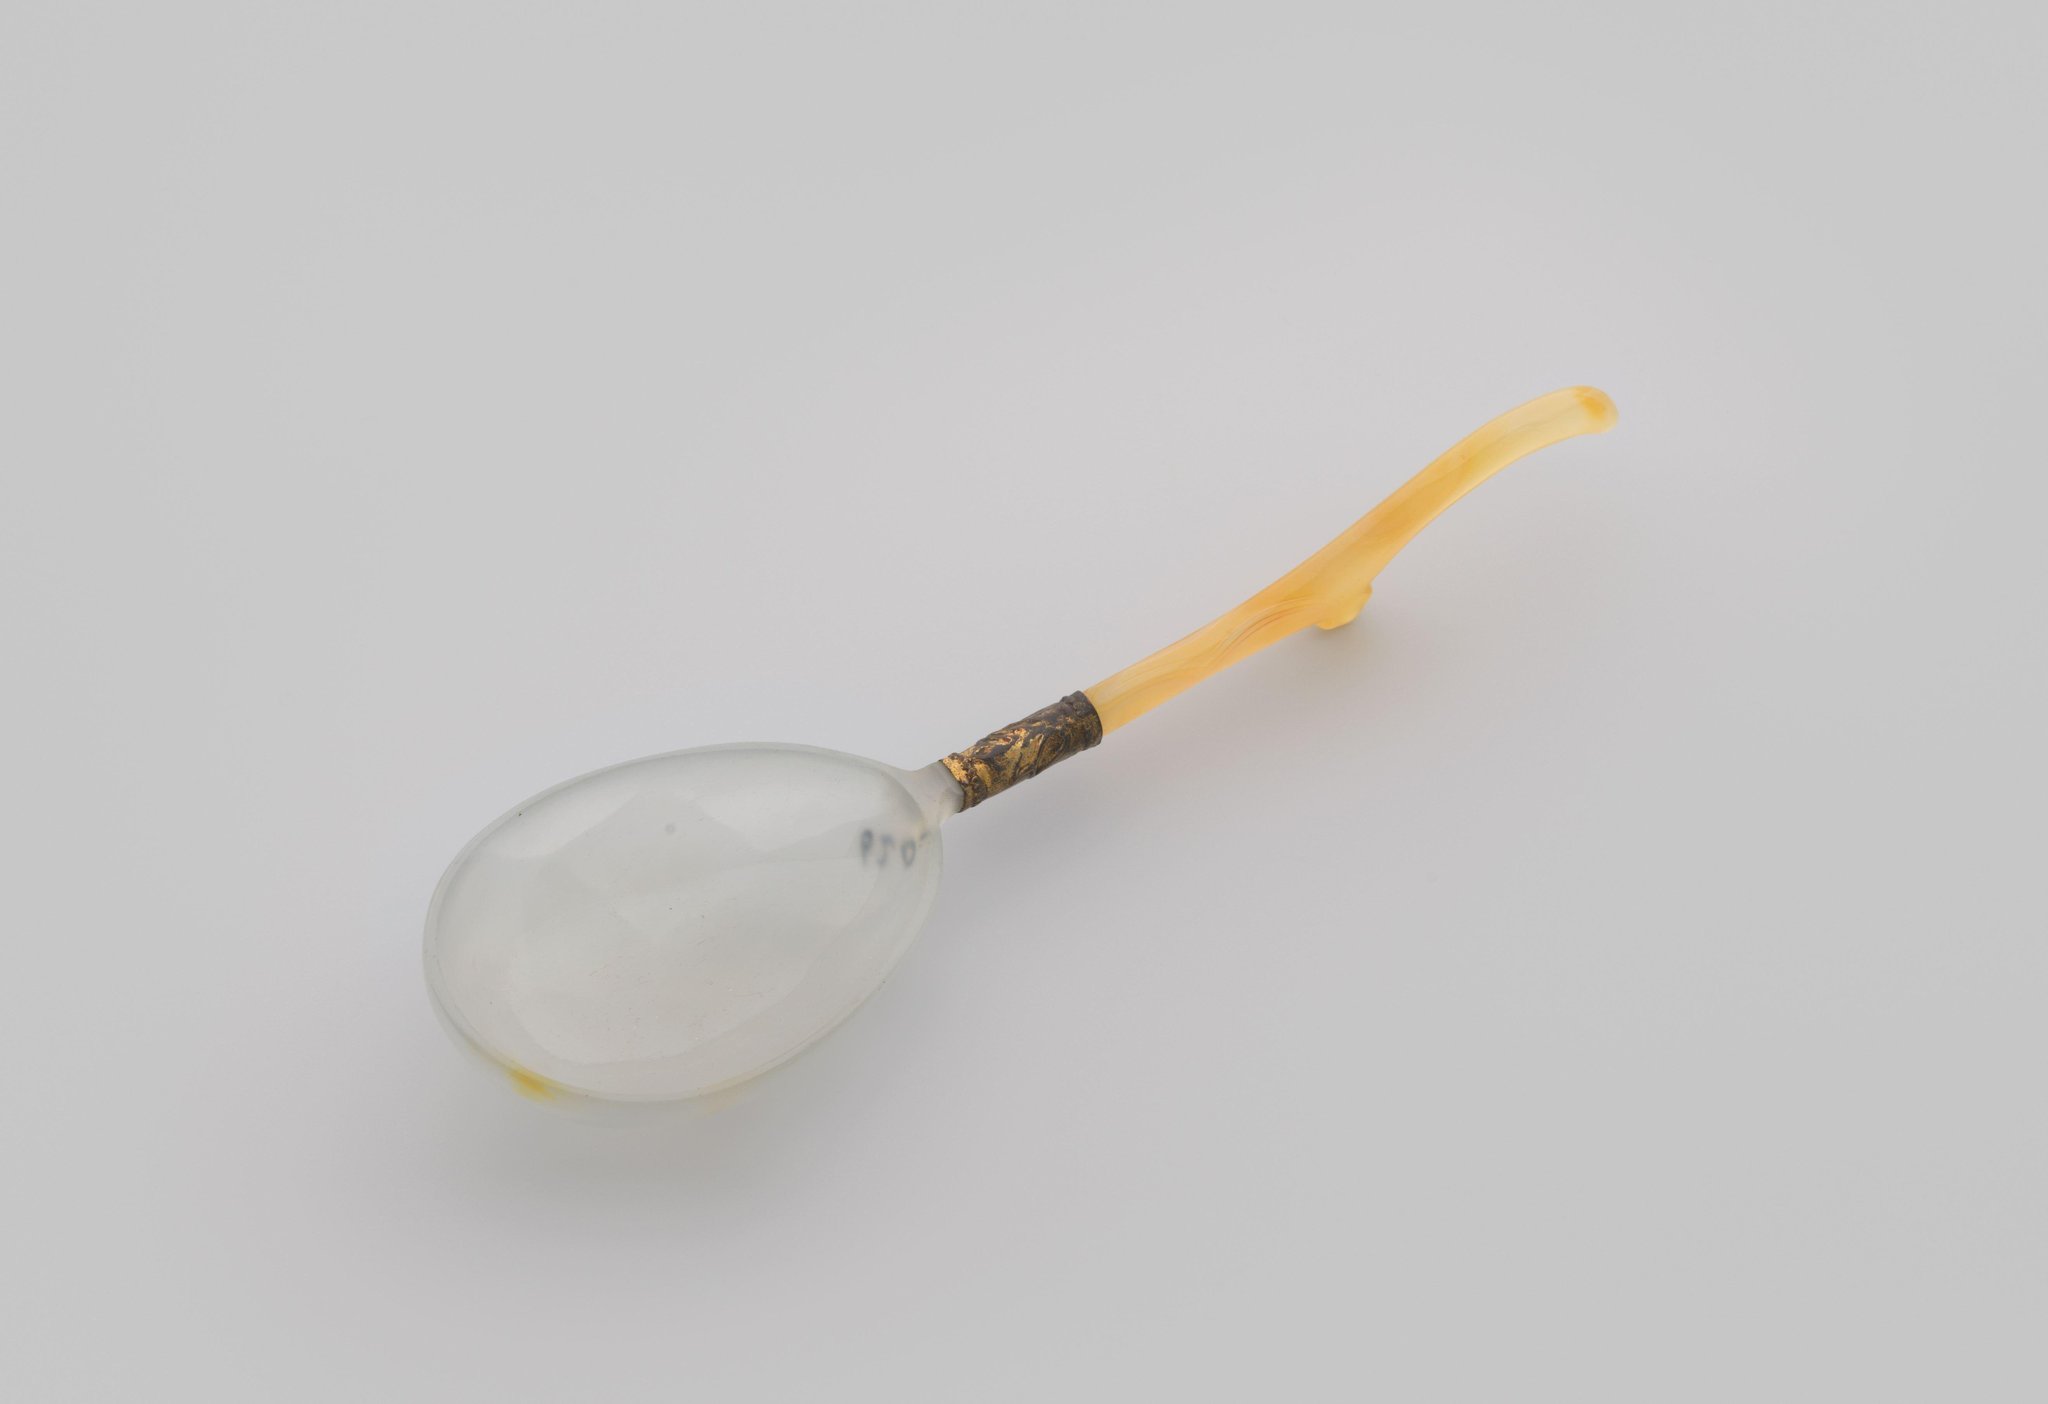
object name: spoon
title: Lepel van grijze en gele agaat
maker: Anonymous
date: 1600-1699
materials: stone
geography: germany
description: Lepel met een ovale bak van grijze agaat en een steel, met haakvormig uiteinde, van gele agaat. Beide delen zijn verbonden door een verguld zilveren band met gestampt ornament.